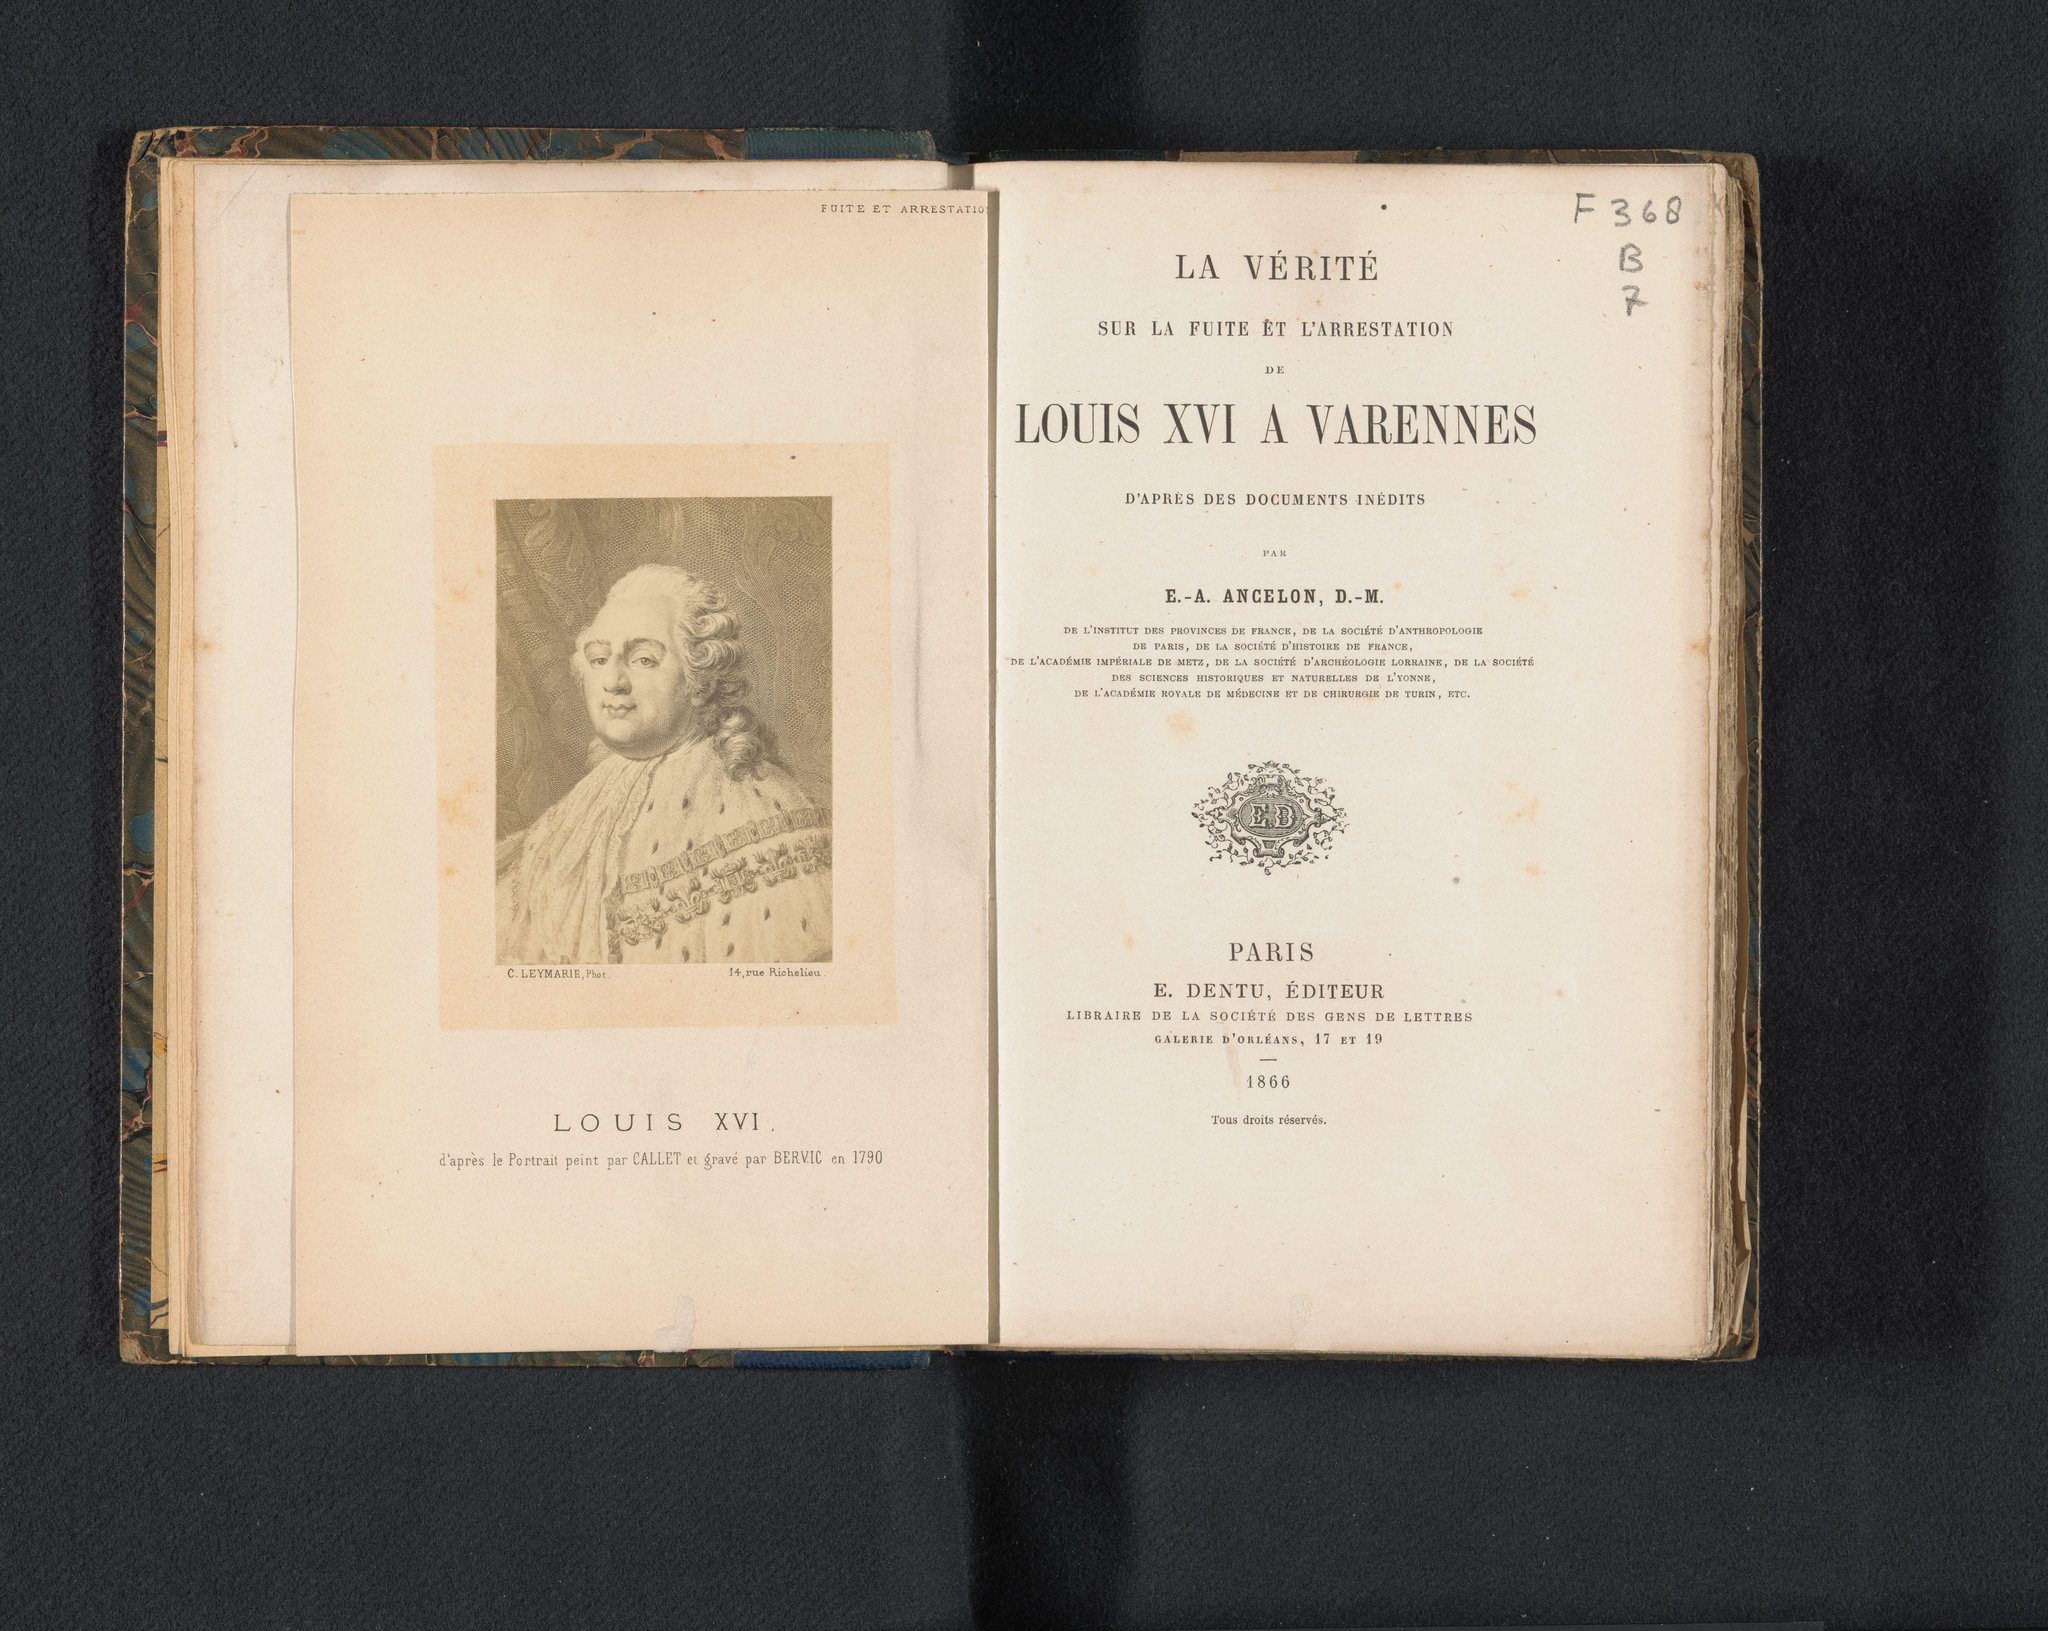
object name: photograph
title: Fotoreproductie van een portret van Lodewijk XVI van Frankrijk naar een schilderij van Antoine-François Callet door Charles Clement Bervic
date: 1861-1866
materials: photographic support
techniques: albumen print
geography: paris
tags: paris, lodewijk xvi (koning van frankrijk), historical persons, king